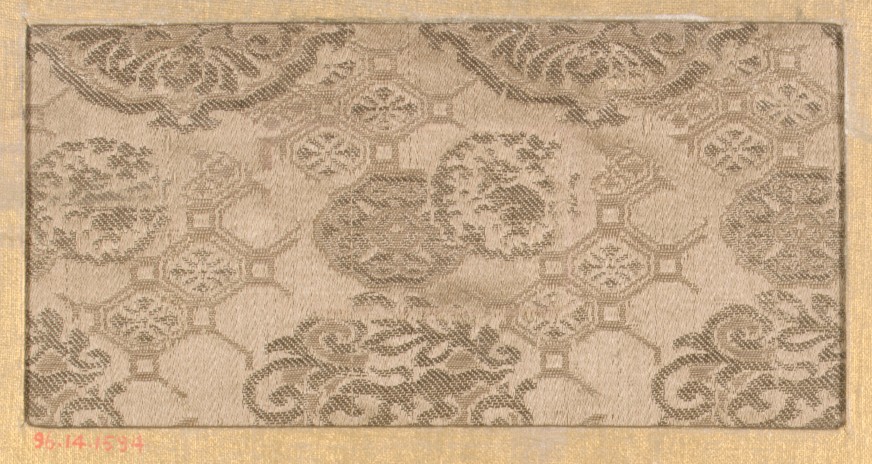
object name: piece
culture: japanese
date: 1701-1900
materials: silk